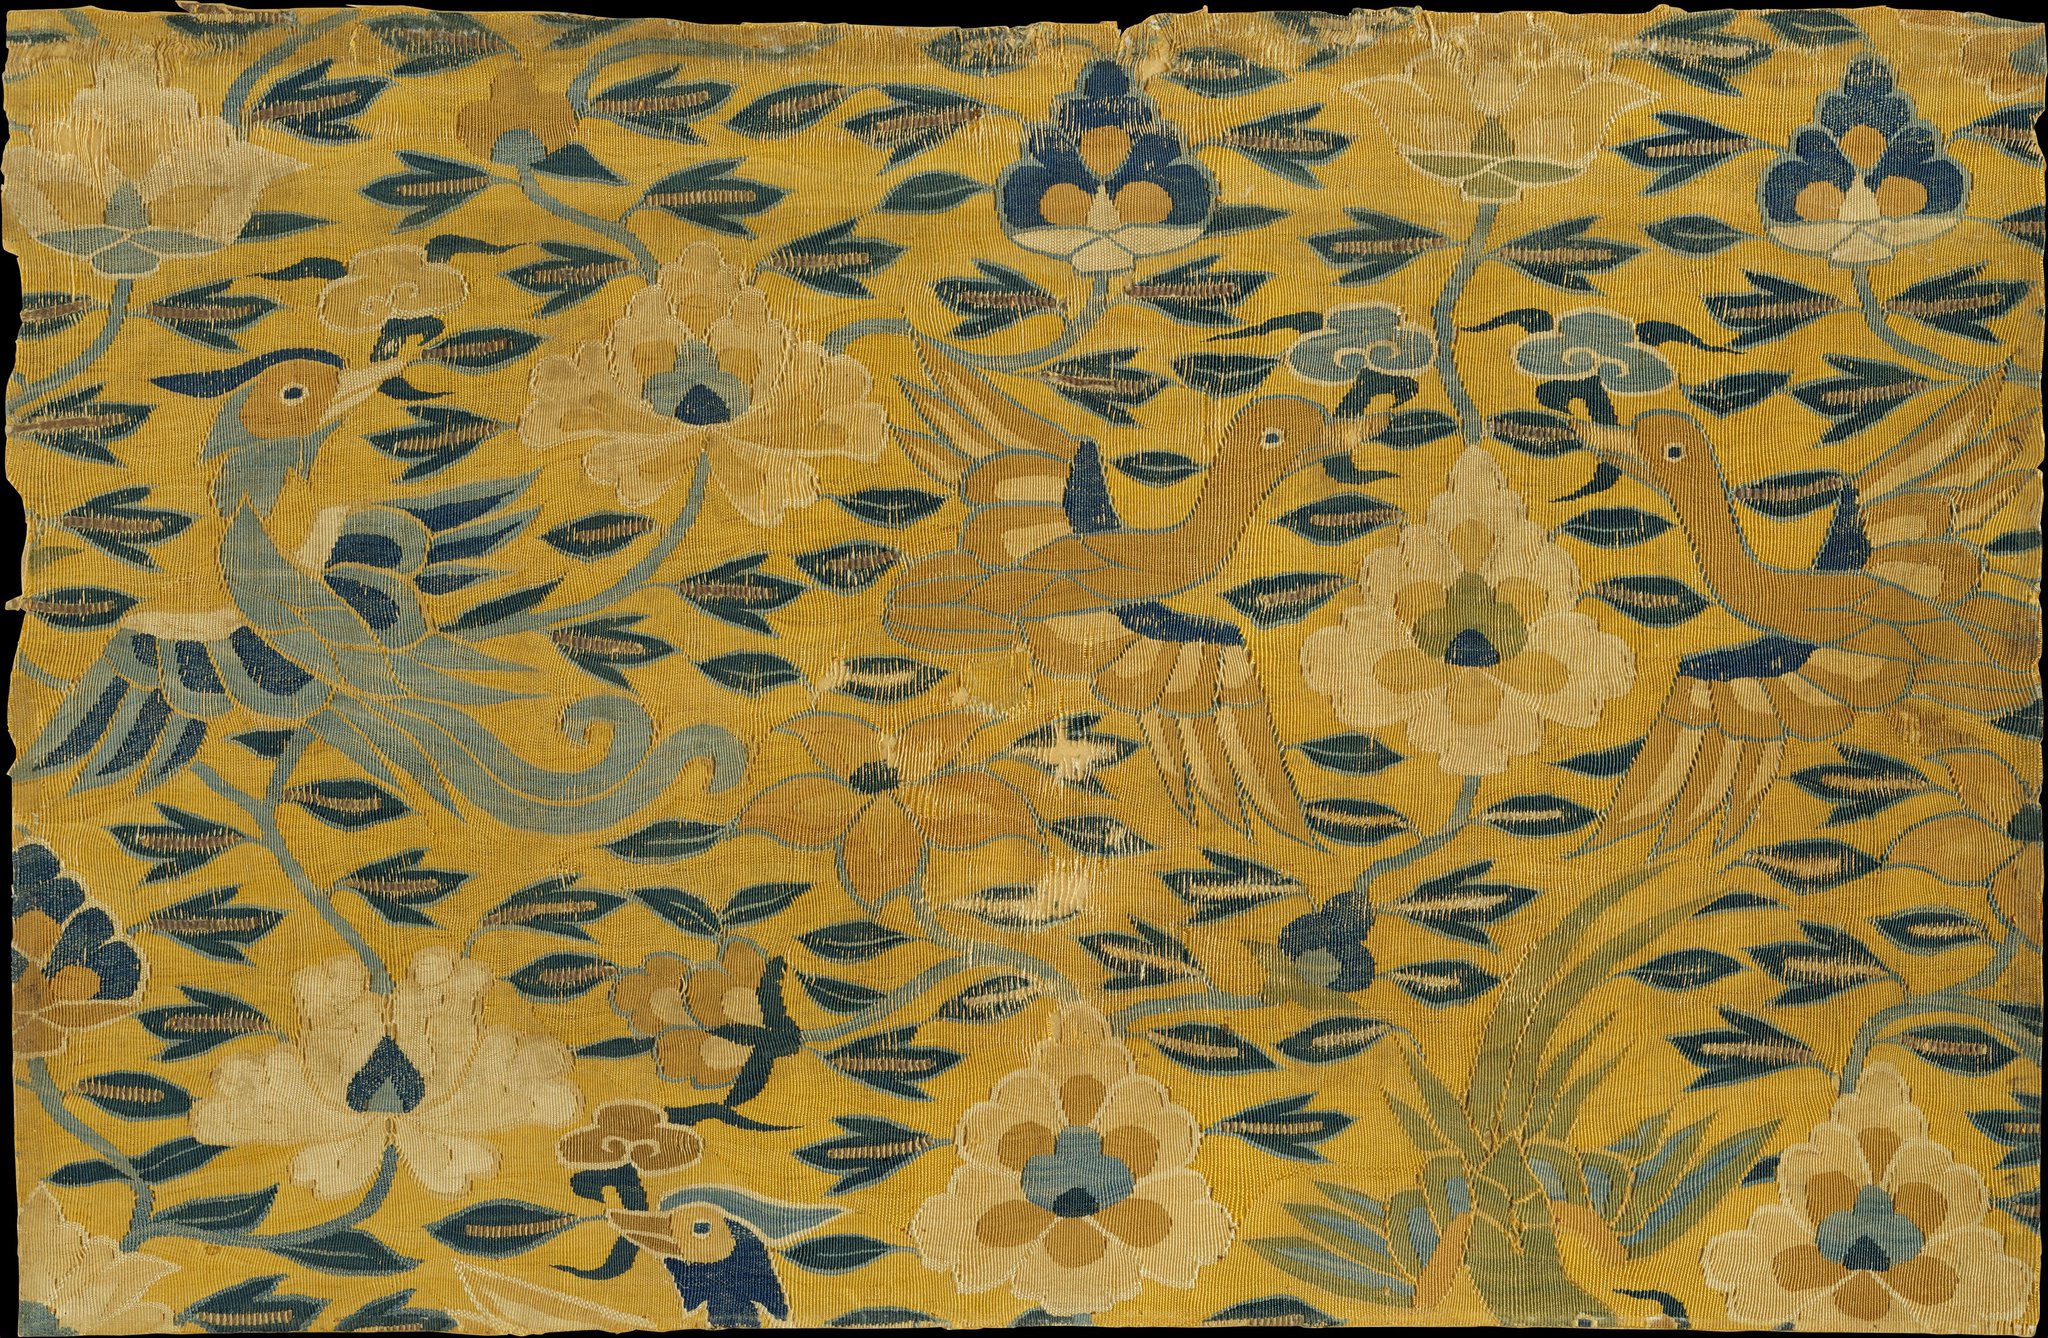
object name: scroll wrapper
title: Scroll Cover with Birds and Flowers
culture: chinese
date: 1101-1200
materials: metal thread, silk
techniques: tapestry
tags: birds,flowers